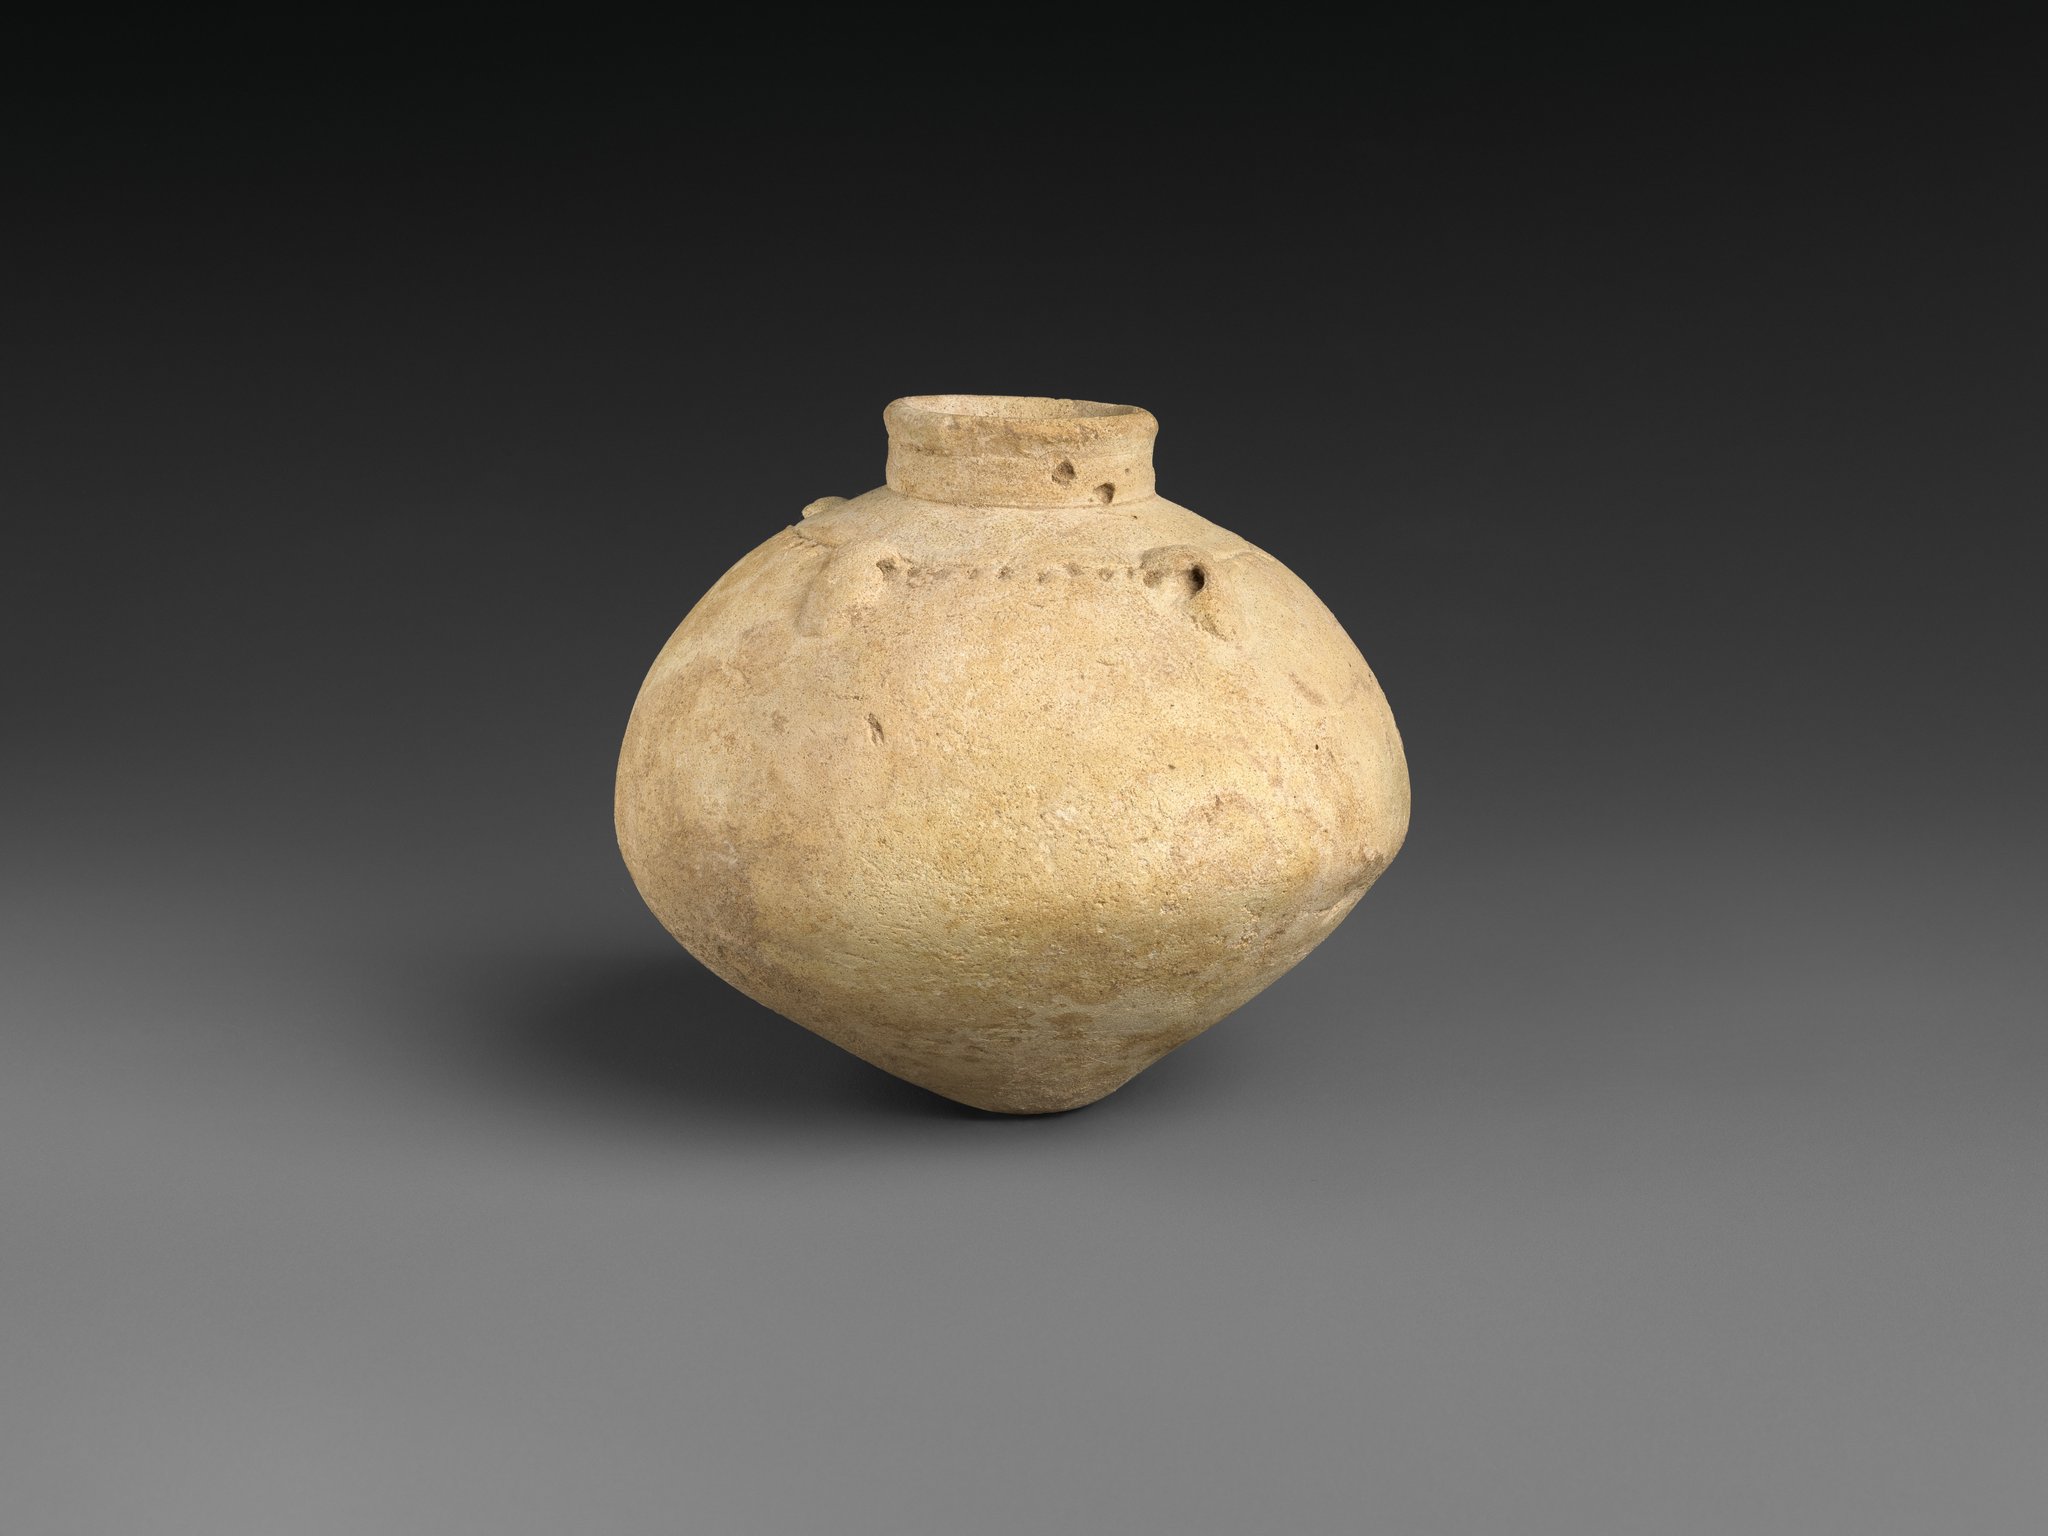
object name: jar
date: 4000-3001 BCE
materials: ceramic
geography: mesopotamia